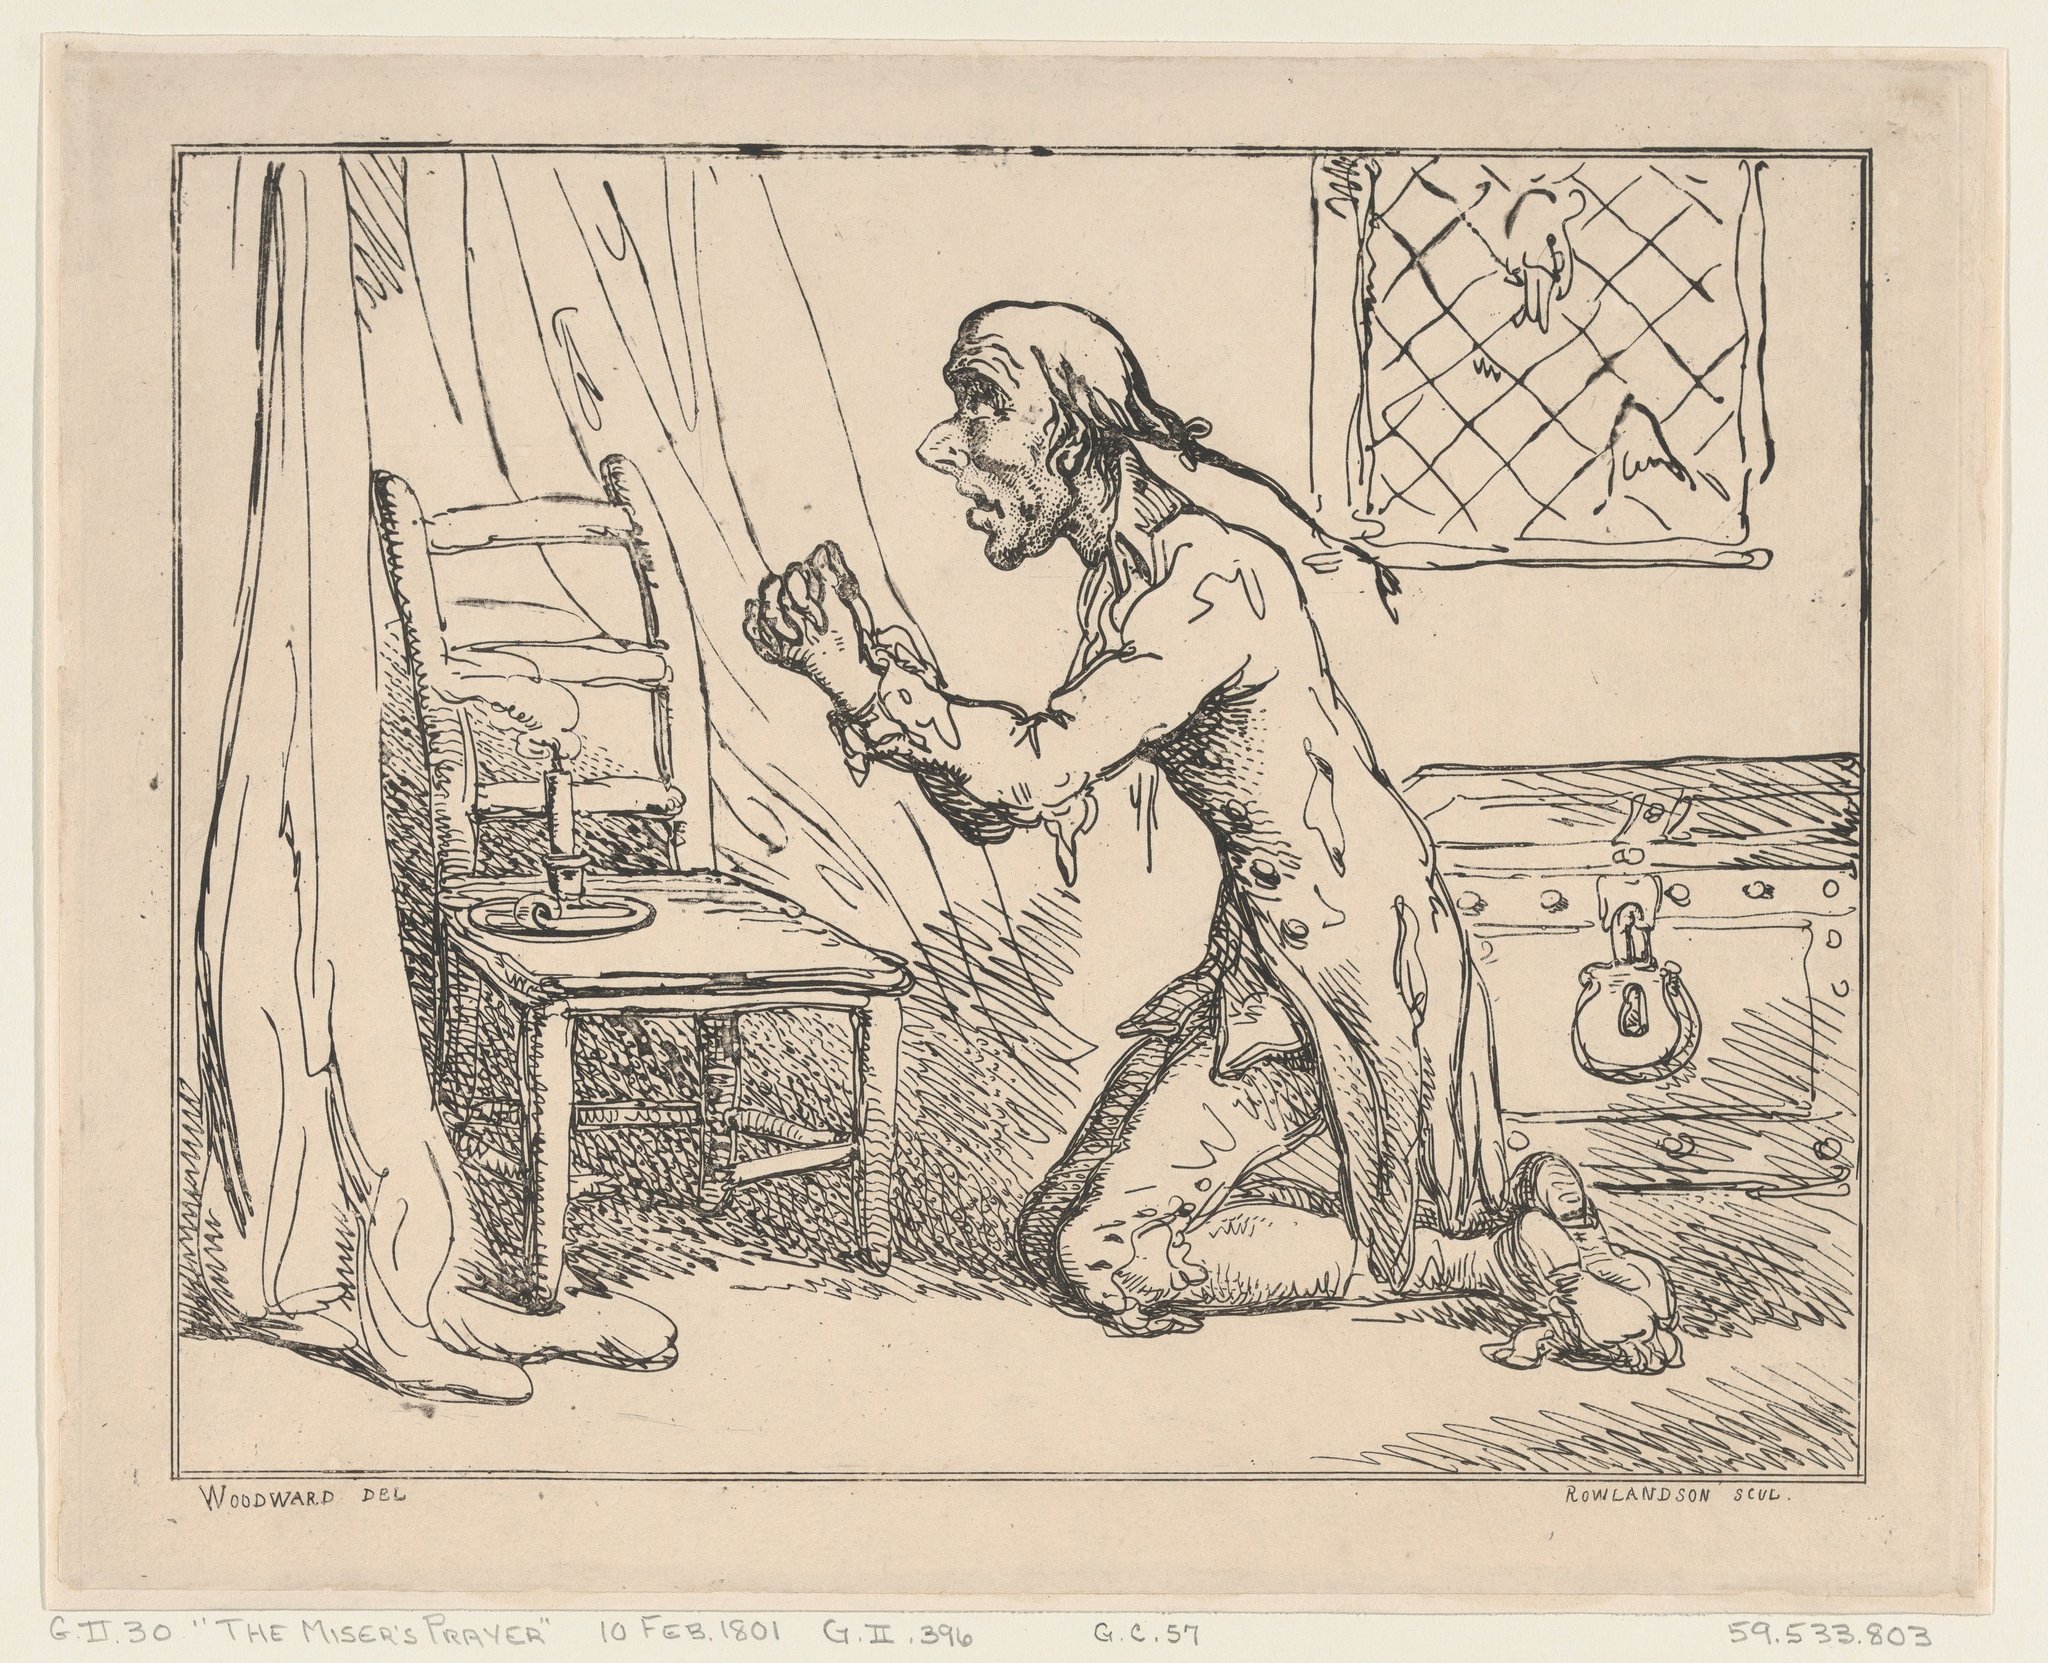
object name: print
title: The Miser's Prayer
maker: thomas rowlandson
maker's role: artist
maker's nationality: british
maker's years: 1757-1827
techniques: etching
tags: men,praying